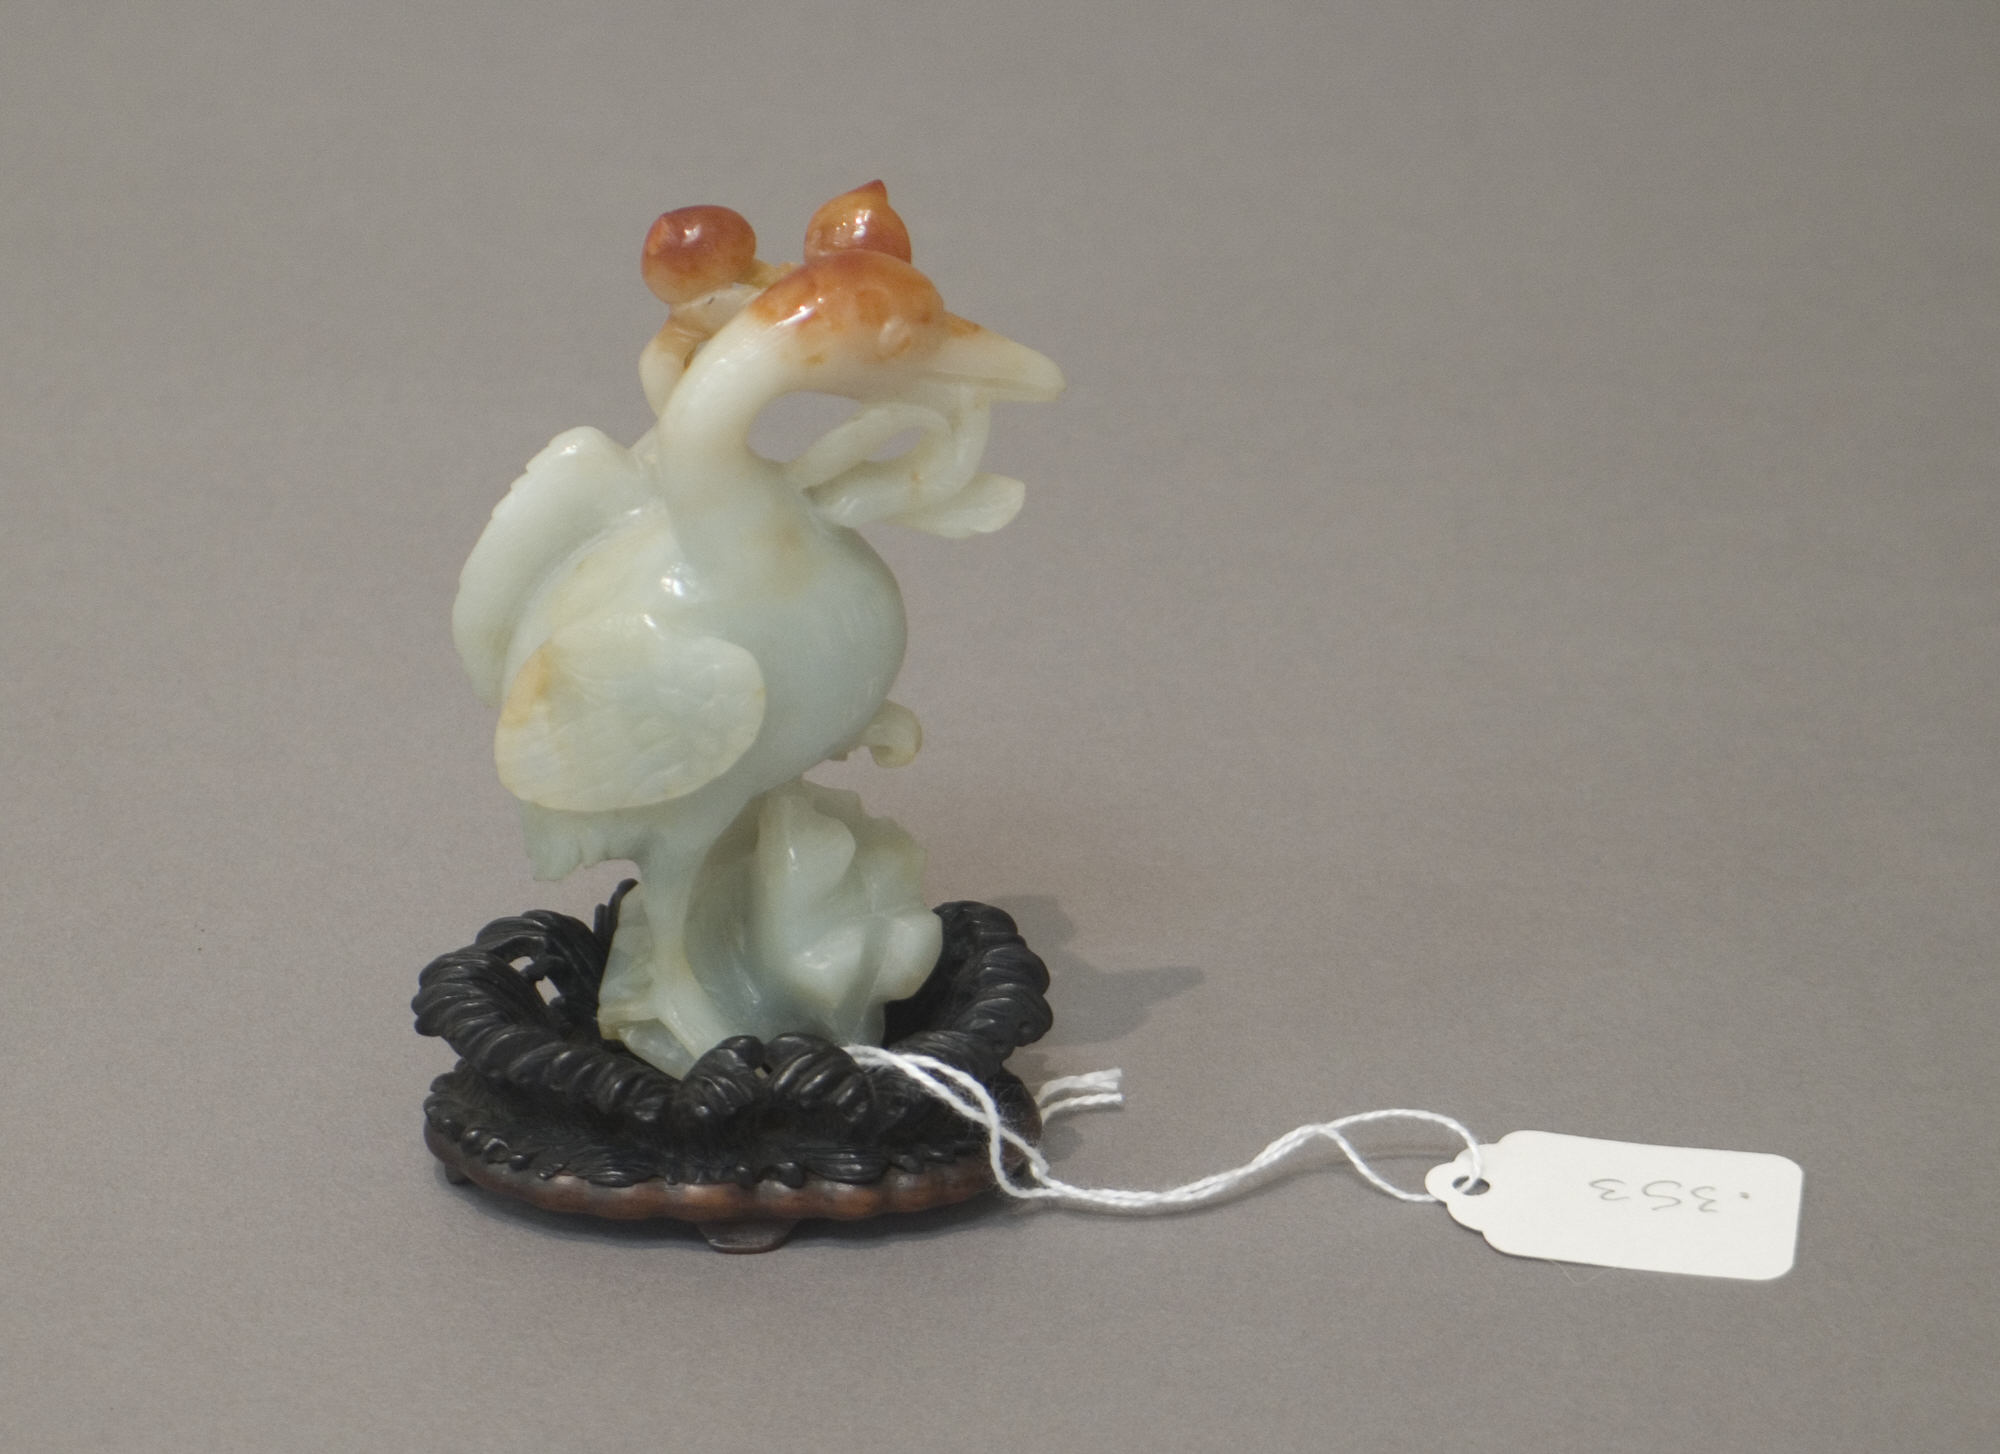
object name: figure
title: Stork with Branch of Peaches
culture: chinese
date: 1368-1644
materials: jade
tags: birds,peaches